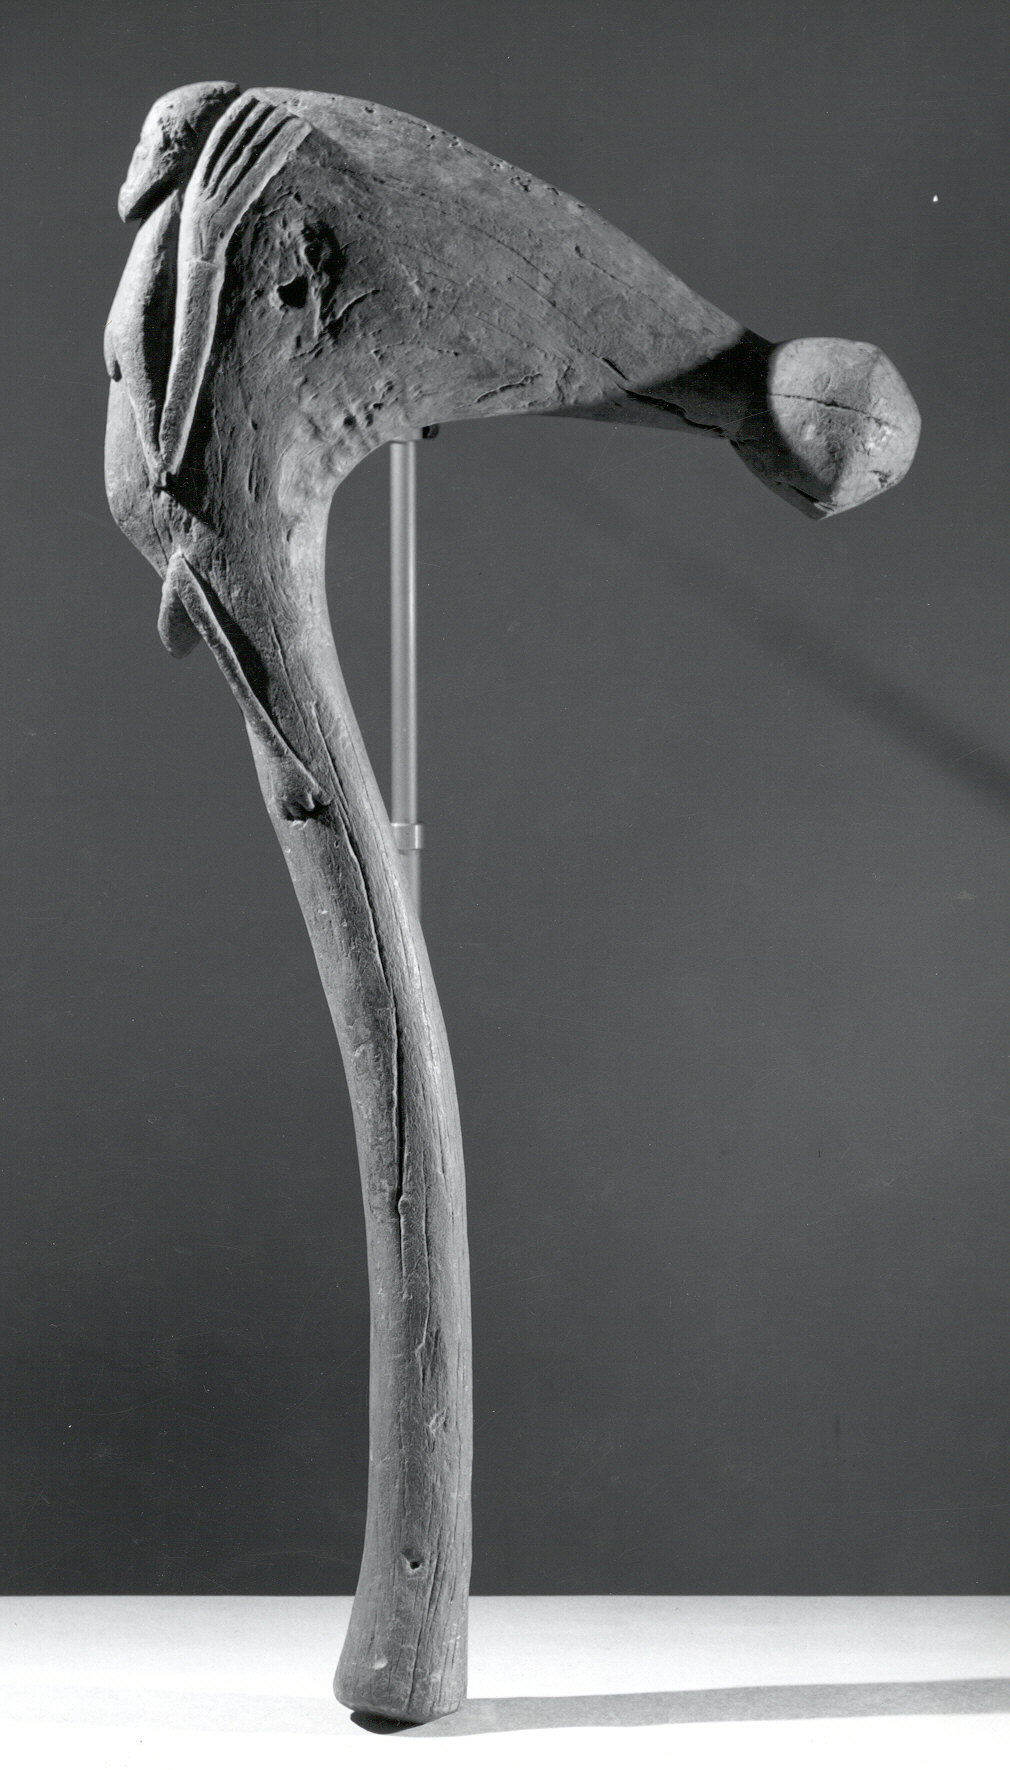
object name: staff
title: Staff: Female Figure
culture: dogon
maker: dogon blacksmith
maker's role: artist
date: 1501-1900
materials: wood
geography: mali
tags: women